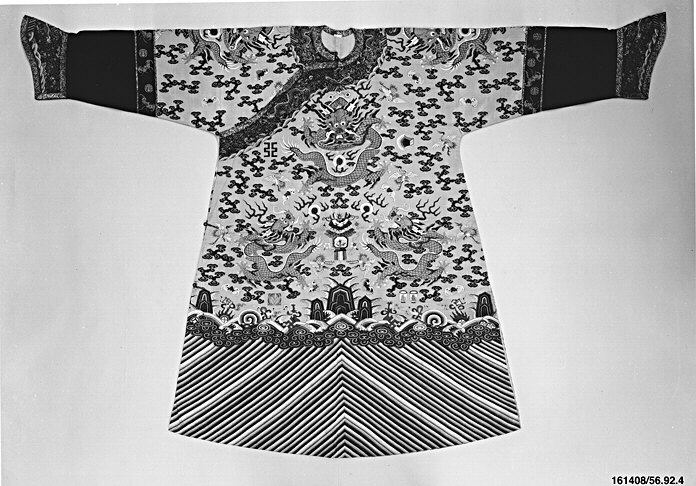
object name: robe, emperor's 12 symbol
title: Emperor's(?) Twelve-Symbol Robe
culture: chinese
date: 1901-2000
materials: silk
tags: dragons